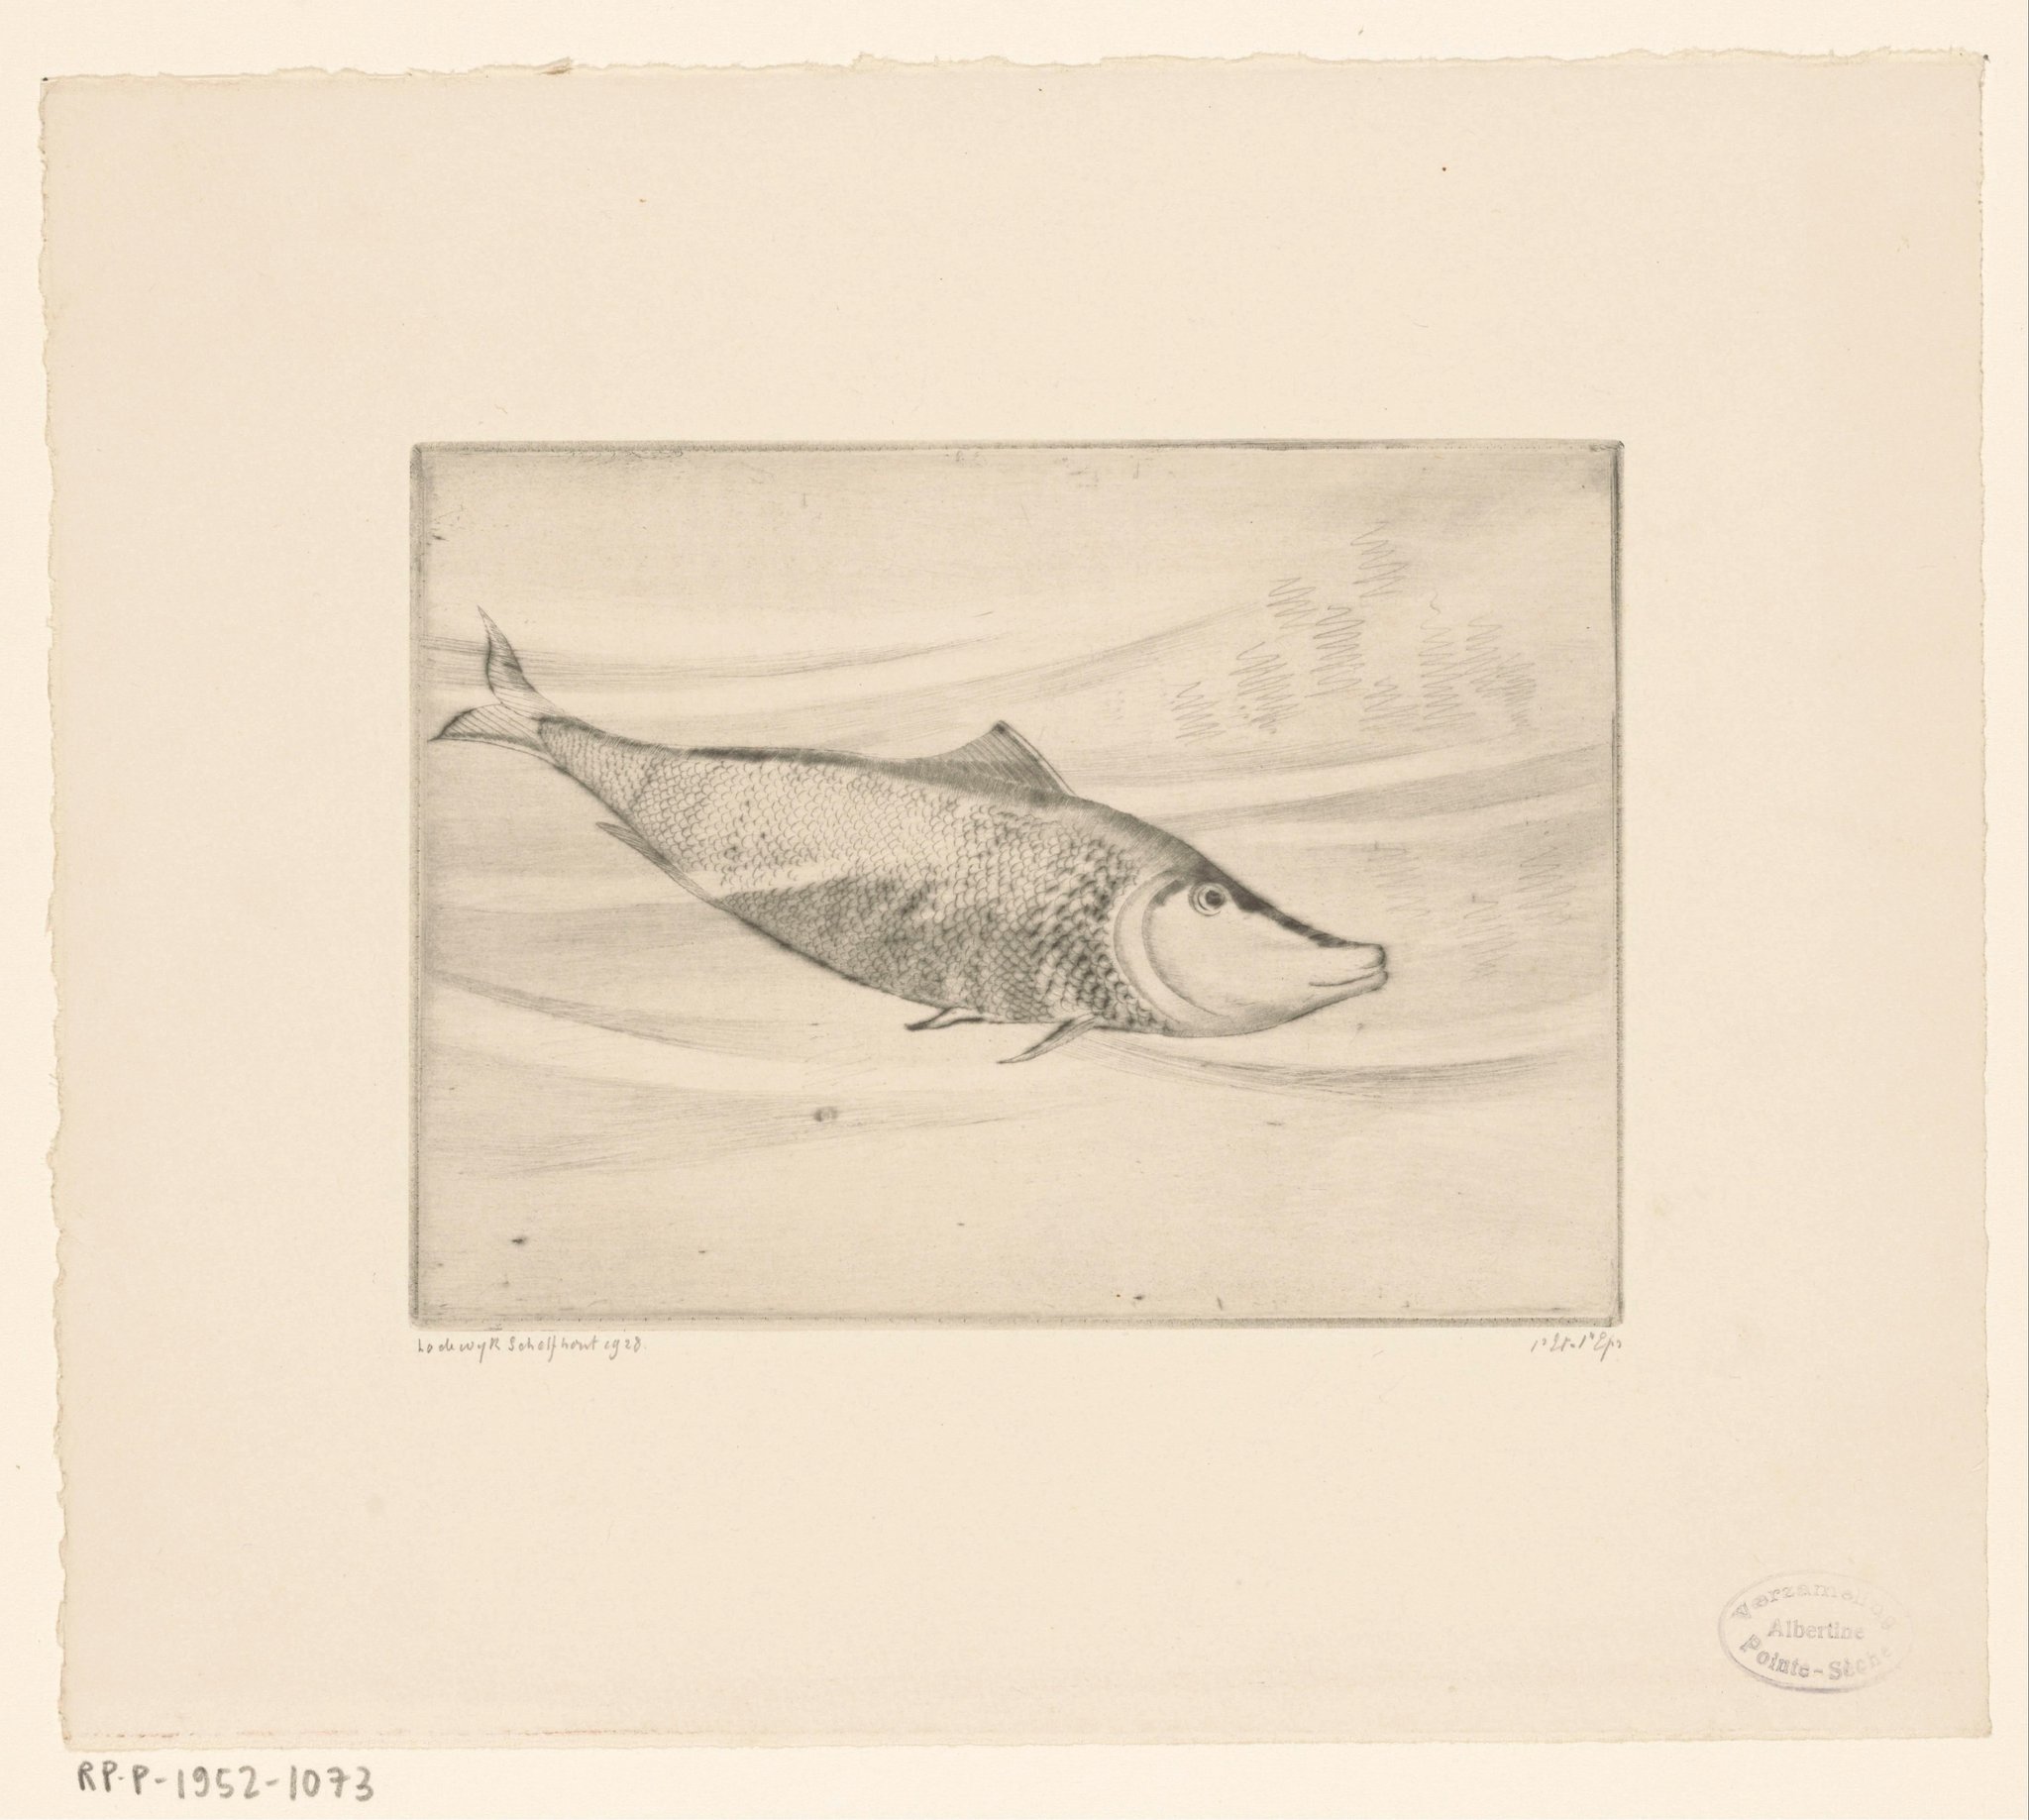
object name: print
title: Sardine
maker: lodewijk schelfhout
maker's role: draughtsman, print maker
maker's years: 1881-1943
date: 1928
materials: paper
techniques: drypoint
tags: bony fishes: sardine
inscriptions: collector's mark: Lugt 5i, collector's mark: Lugt 2228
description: Een zwemmende sardien (Sardina pilchardus).